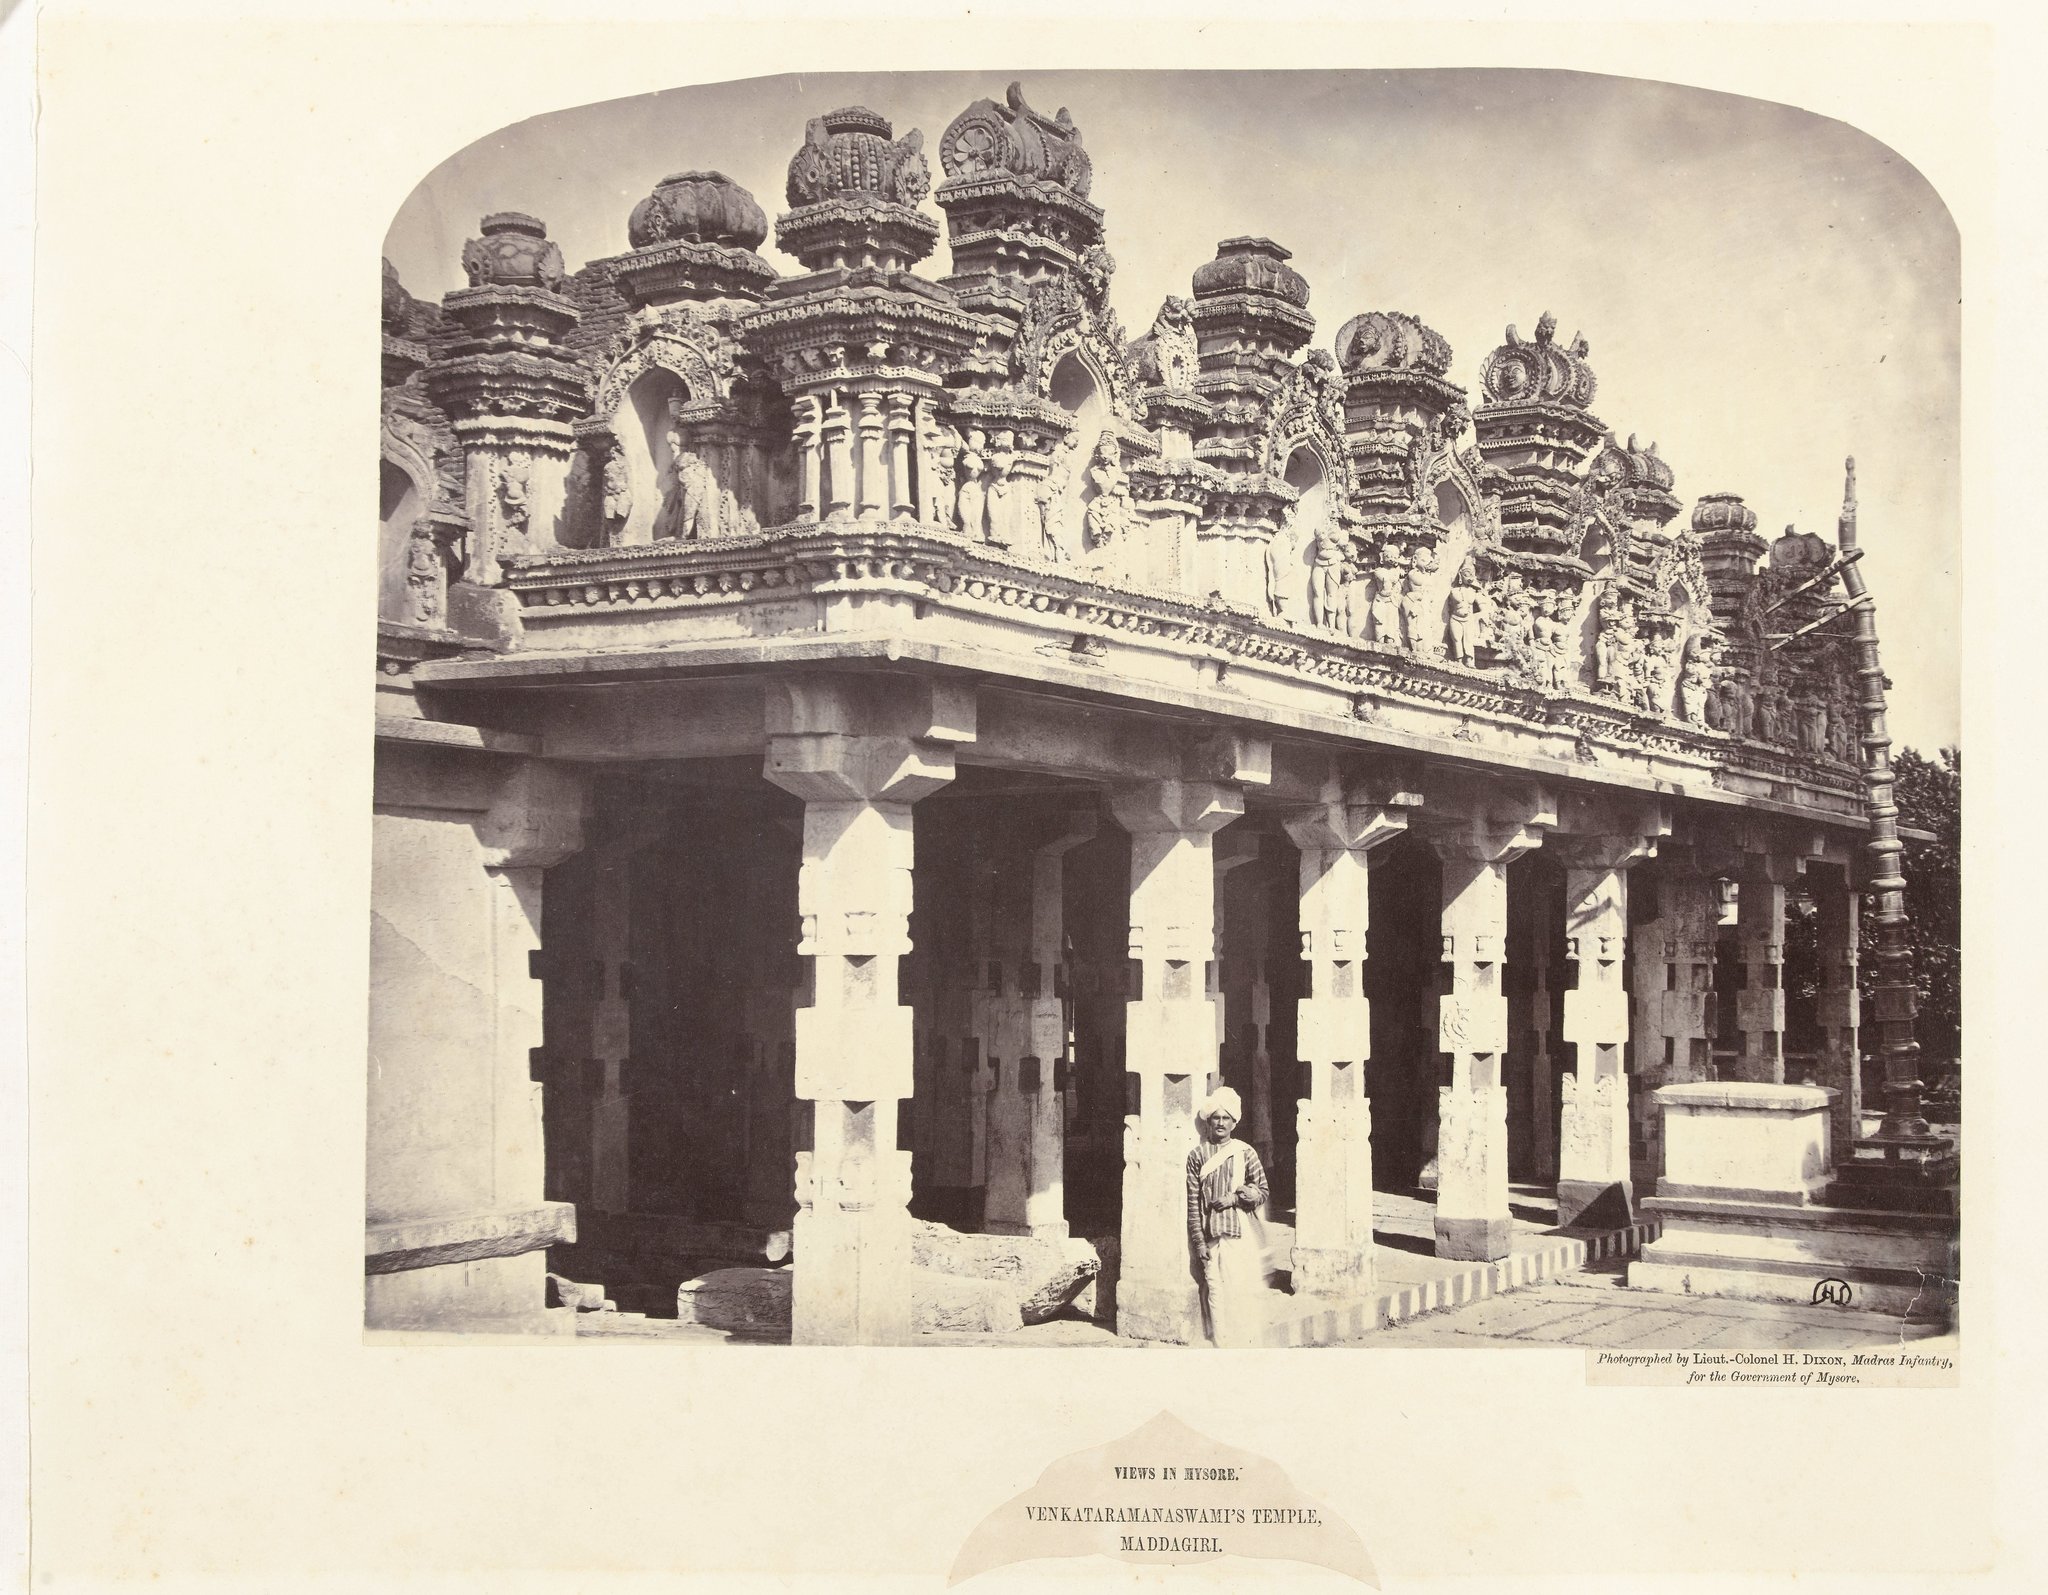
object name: photograph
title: Tempel van Venkataramanaswami in Madhugiri, India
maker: henry dixon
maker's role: fotograaf, luitenant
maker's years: 1824-1883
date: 1865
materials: cardboard, paper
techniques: albumen print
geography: mysore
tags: temple, shrine ~ hinduism, buddhism, jainism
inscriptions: number: ‘54’, inscription: ‘Photographed by LIEUT. COLONEL H. DIXON, Madras Infantry/ For the Govt. of Mysore.’, signature: ‘HD’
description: Niet te verwarren met Henry Dixon (1820-1983, RP-F-1996-260); de hier bedoelde Henry Dixon was luitenant-kolonel in het Engelse leger. Dixon werd na 1868 bevorderd tot Lieutenant-Colonel en ging in 1872 - in die rang - met pensioen (History of Photography 1981, pp. 129-131)